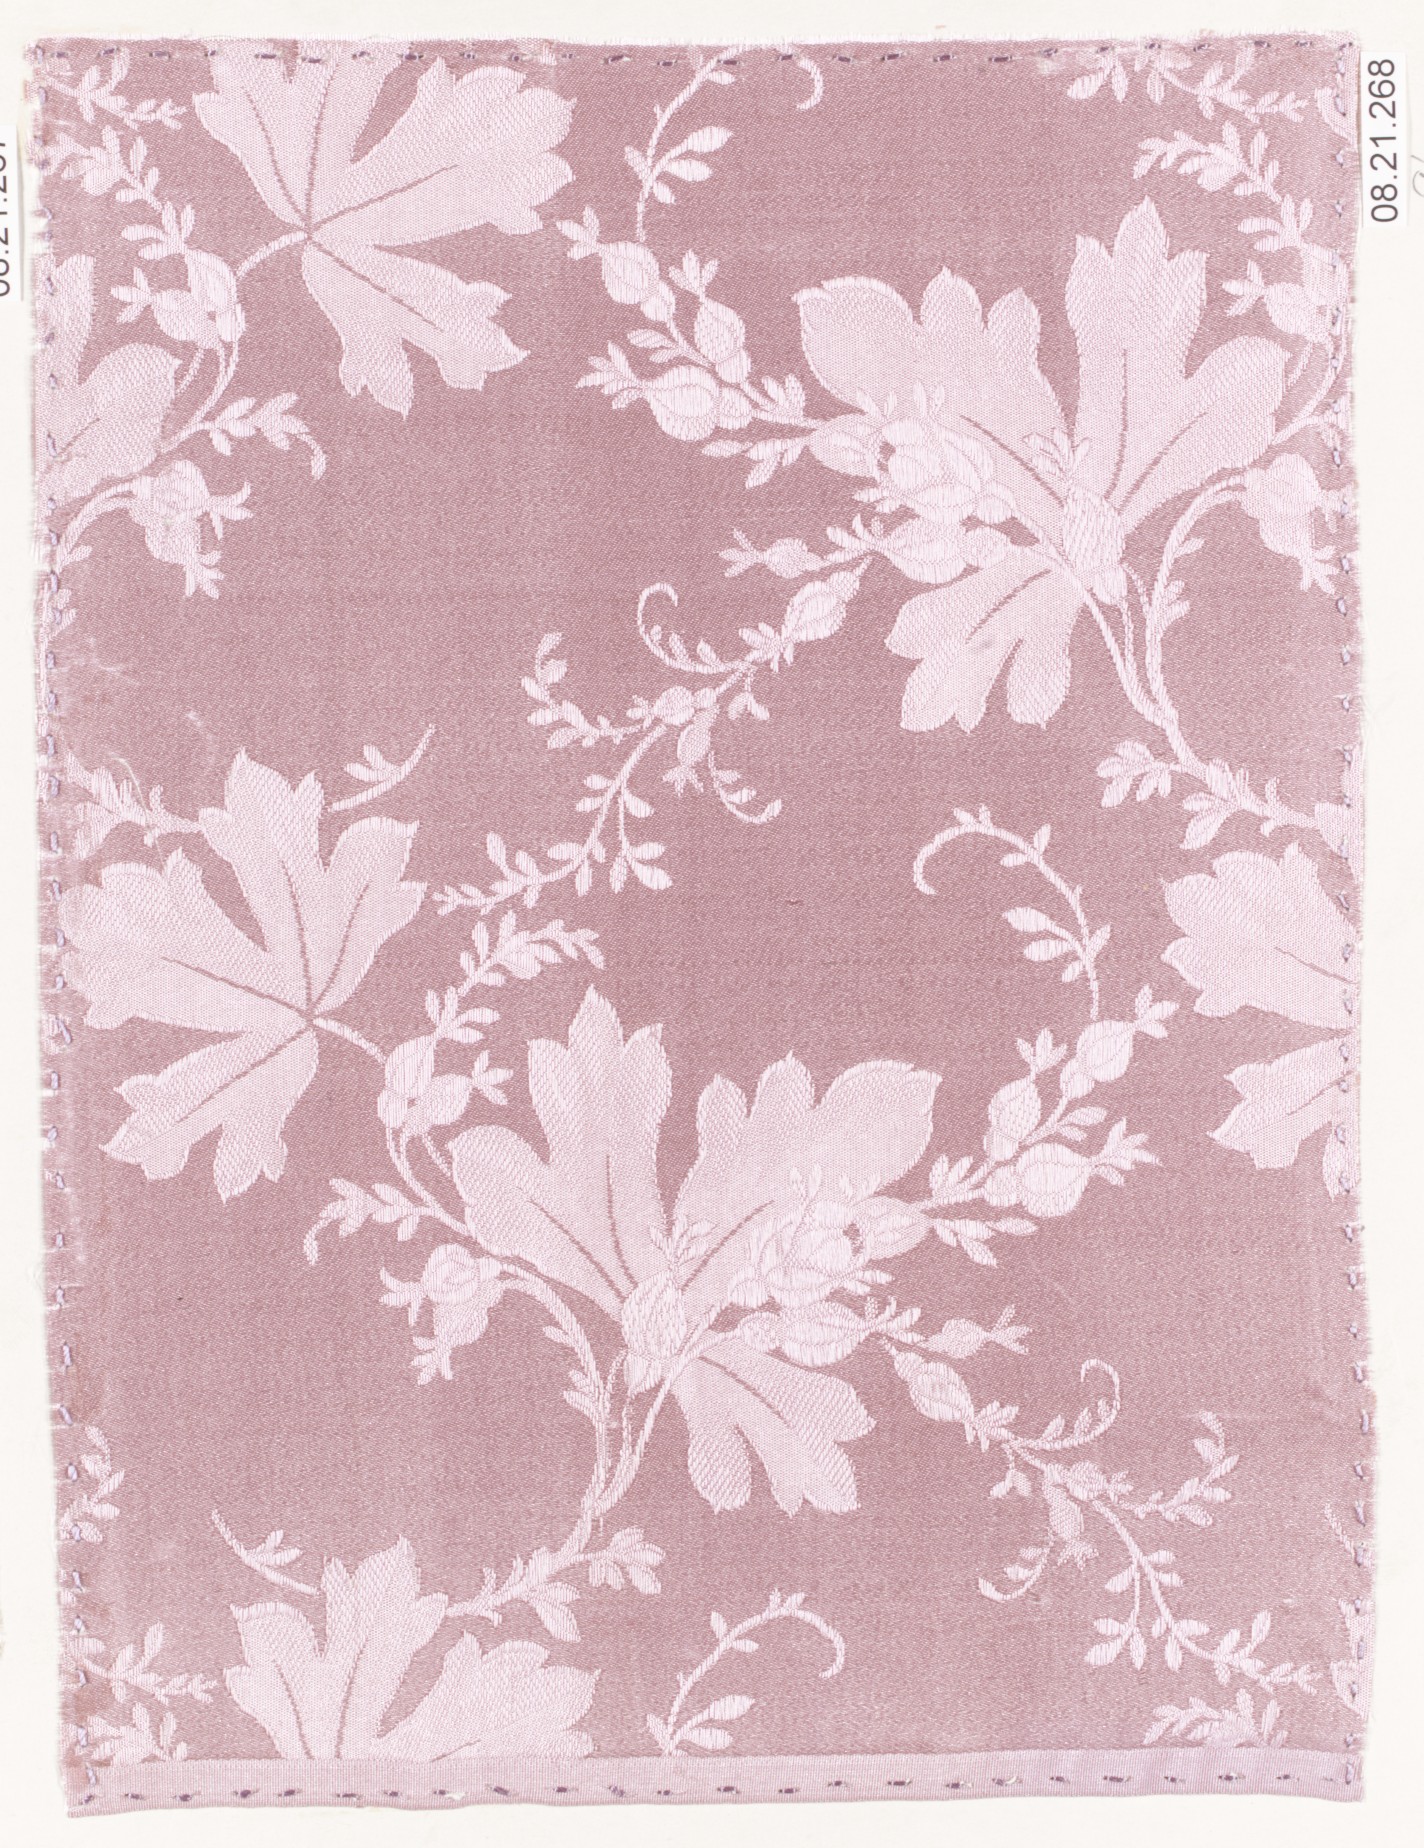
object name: textile sample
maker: Anonymous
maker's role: designer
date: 1900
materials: silk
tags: leaves